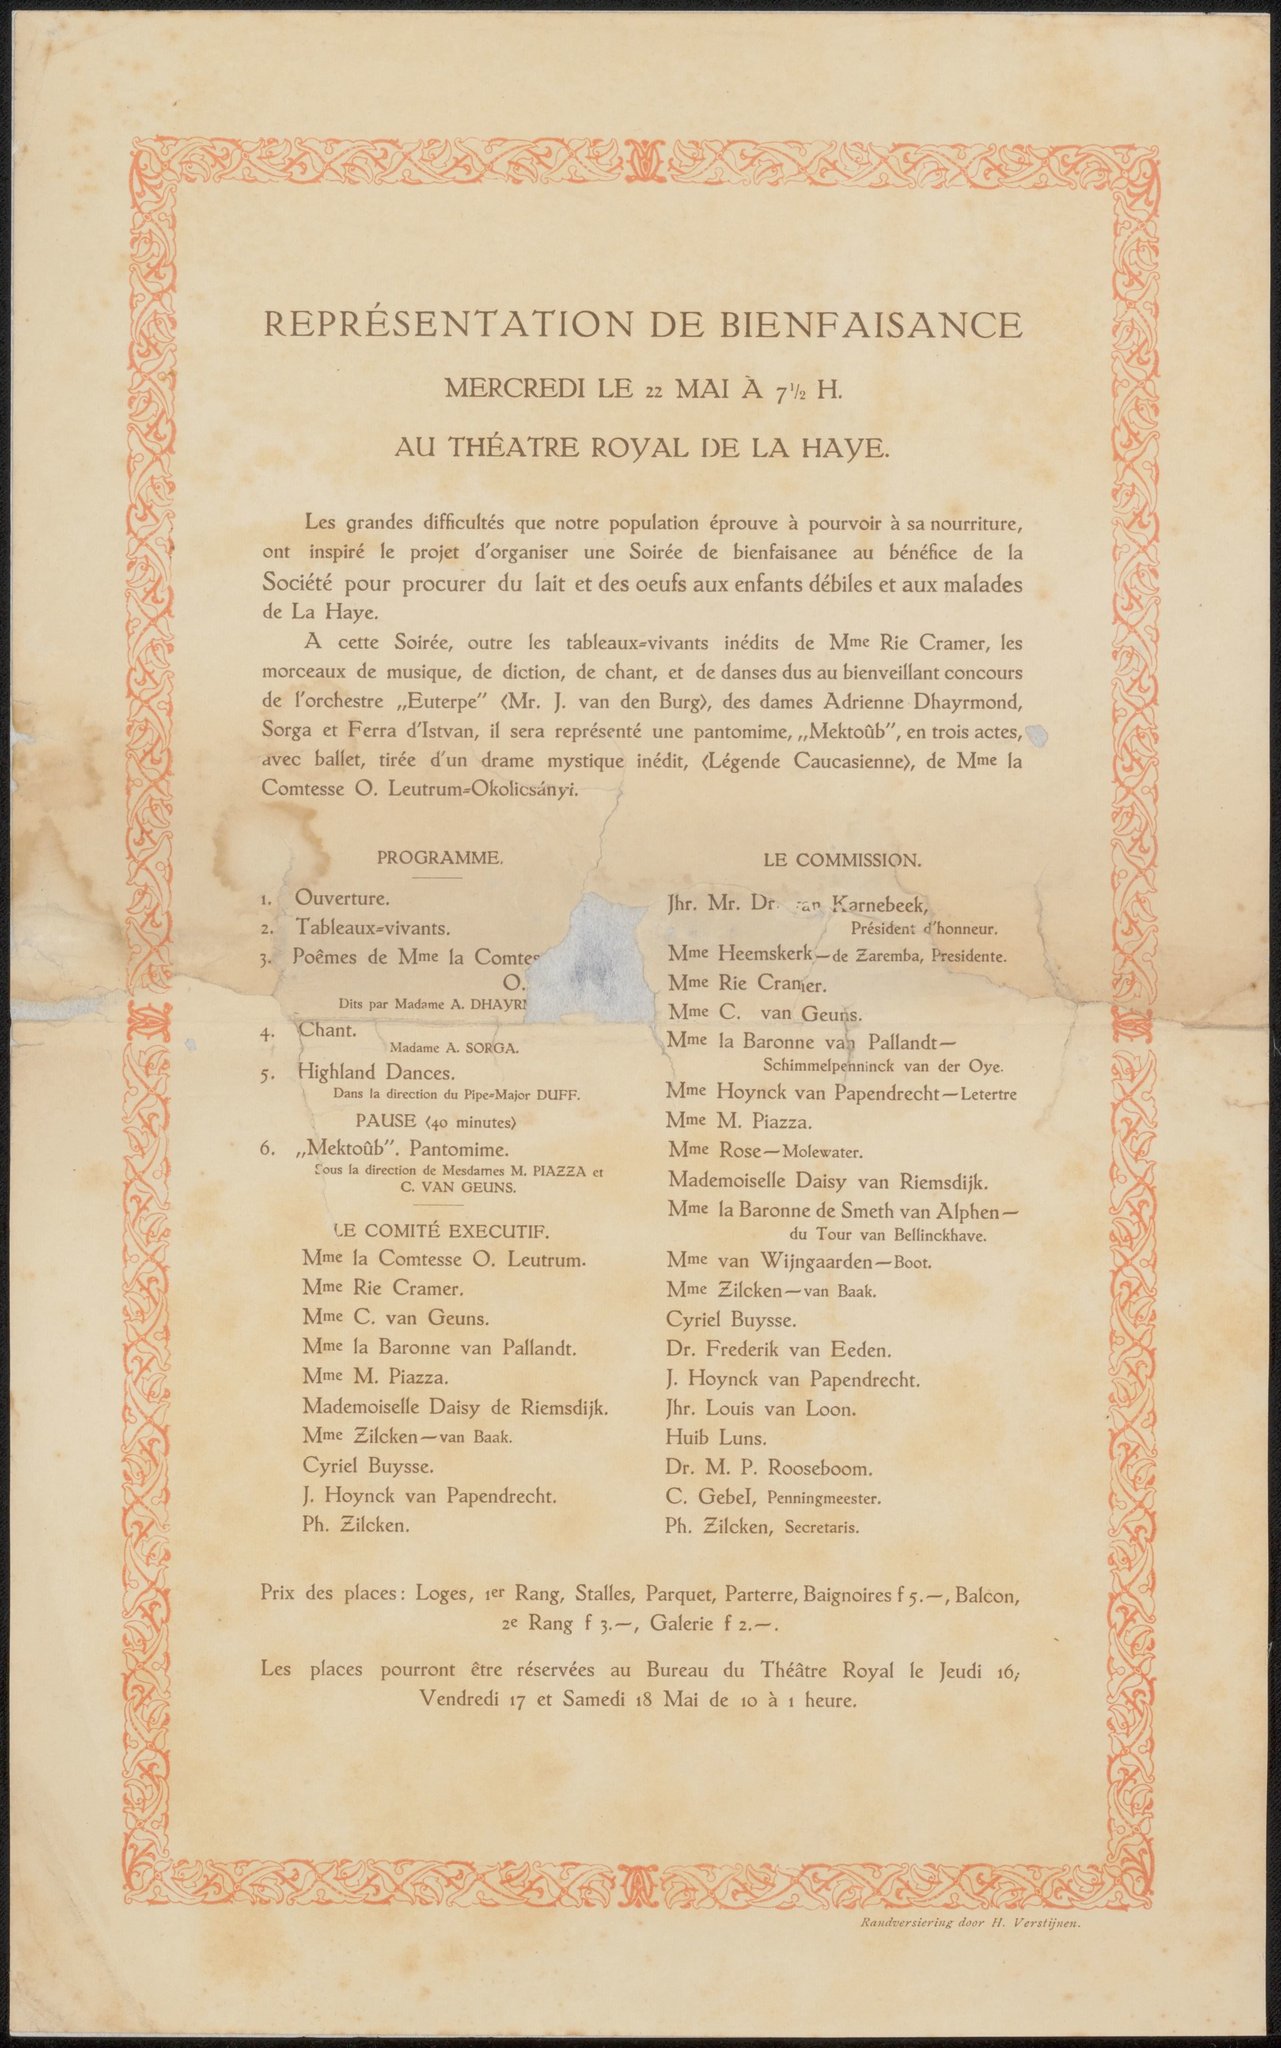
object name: programma, programmaboekje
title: Programma uit archief Philip Zilcken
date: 1918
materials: paper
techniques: printing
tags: print maker, rie cramer, gravin olga leutrum von ertingen-okolicsanyi d’okolica, adrienne dhayrmond, the hague, painter, draughtsman, philip zilcken, music, charitable works, the arts of the stage: ballet, theatre, musical drama, motion picture